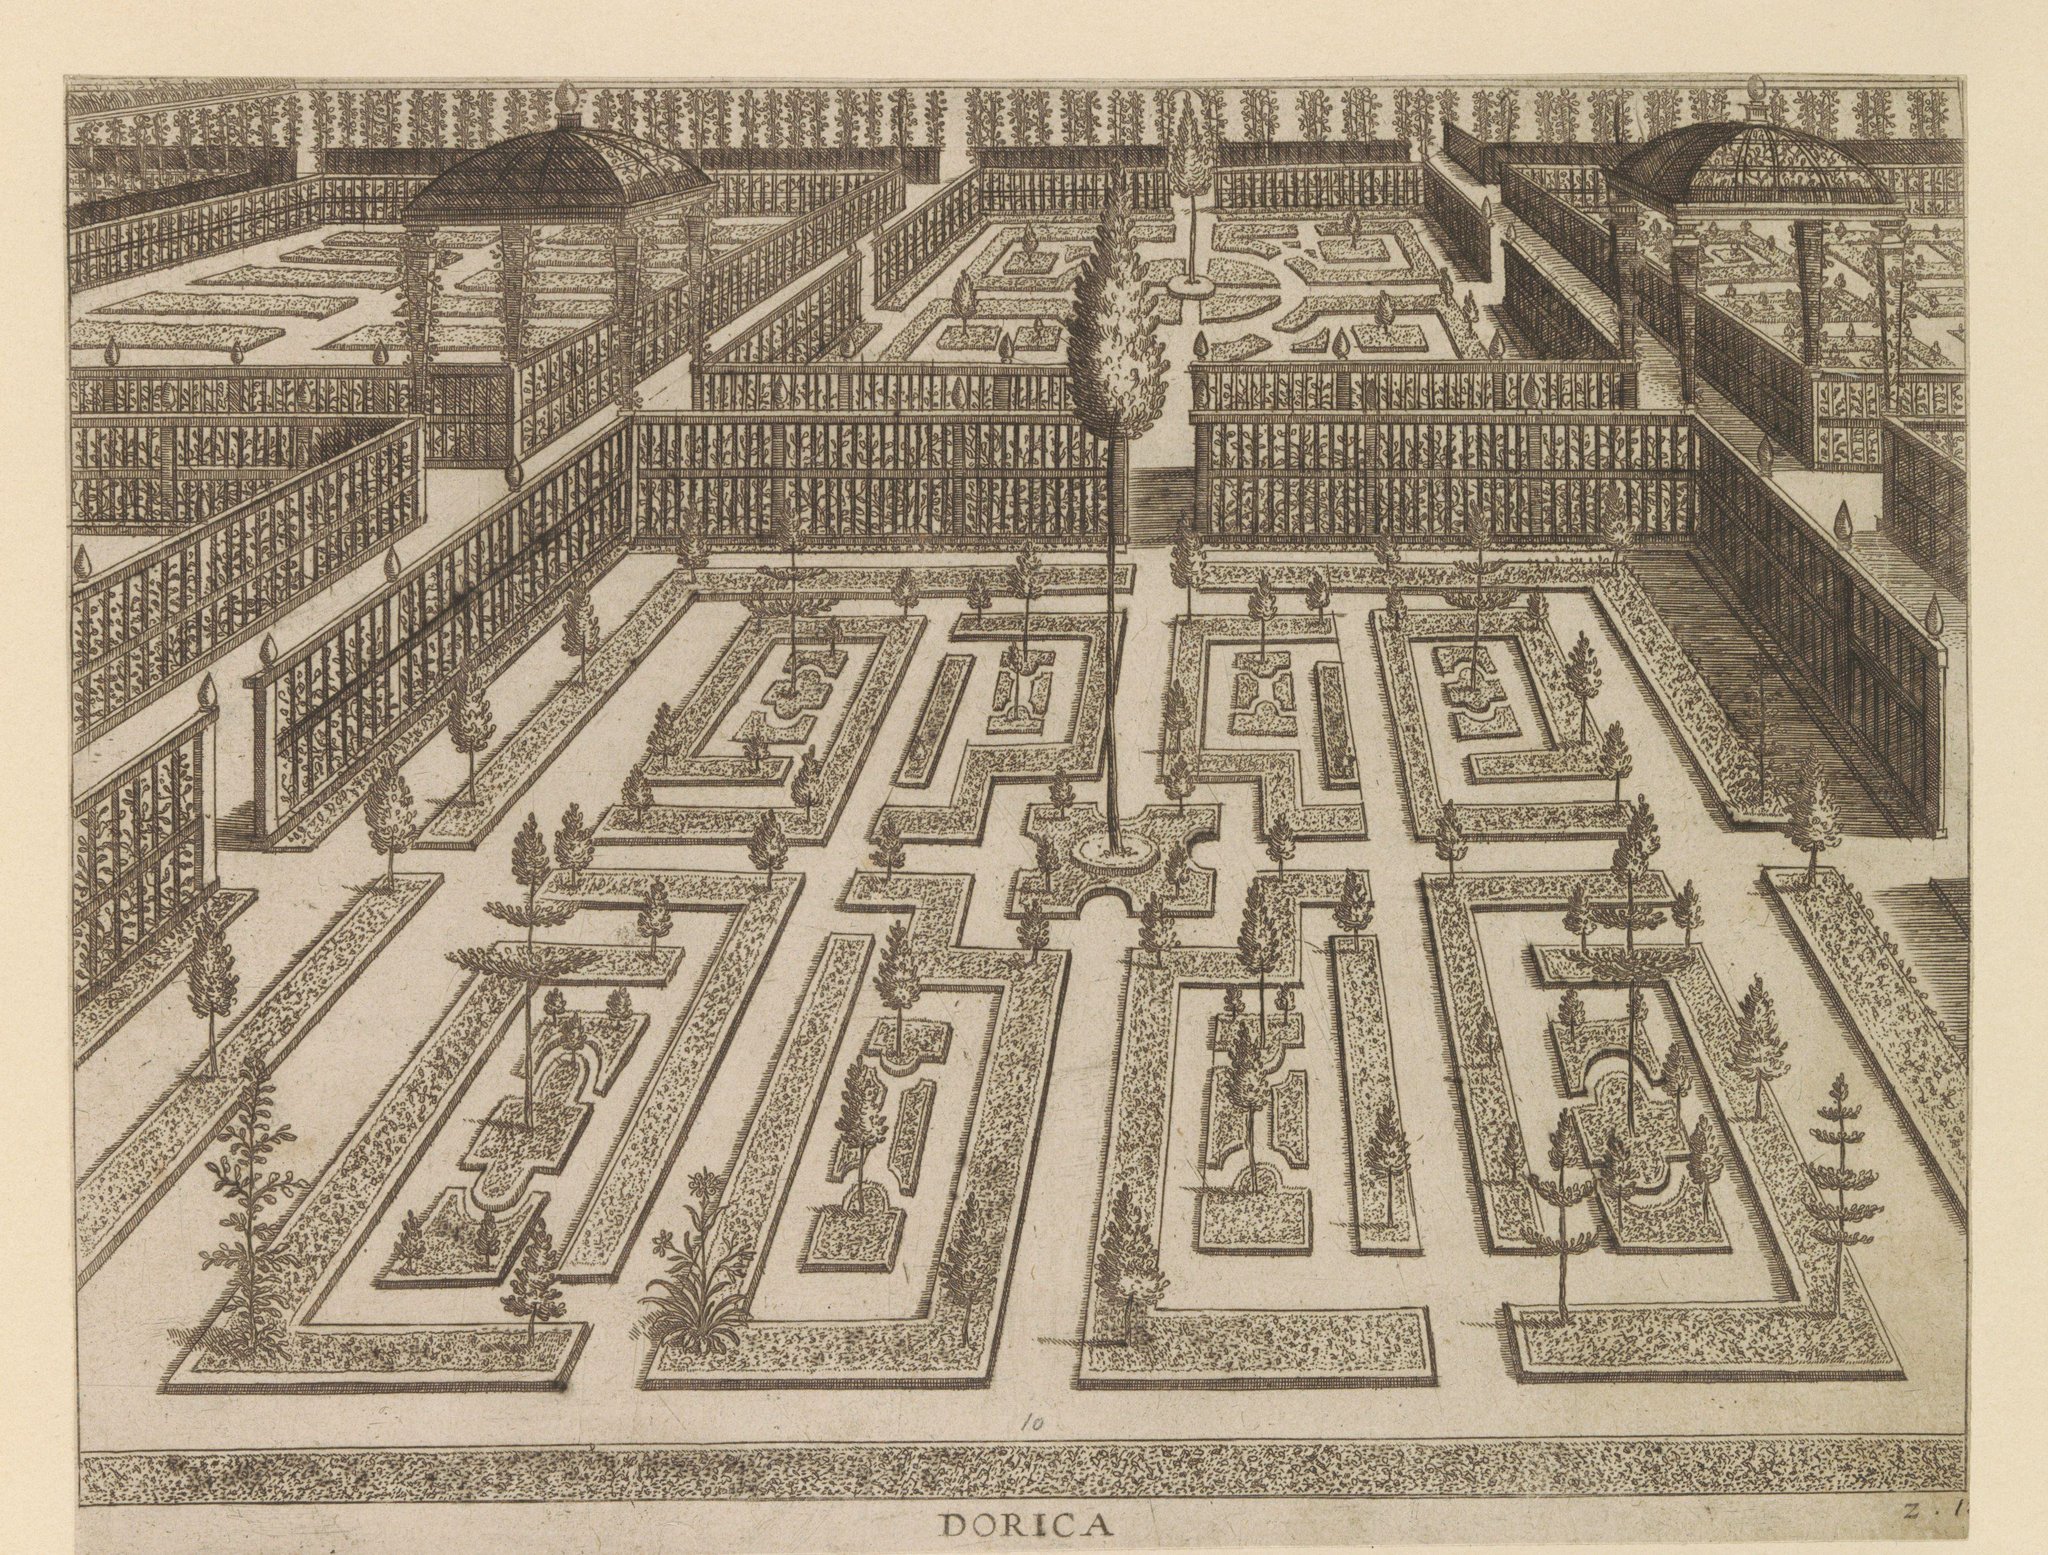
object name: ornament print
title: Tuin met een parterre bestaande uit acht rechthoekige compartimenten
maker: Anonymous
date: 1583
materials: paper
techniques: etching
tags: garden, french or architectonic garden; formal garden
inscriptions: inscription: ‘10’, inscription: ‘1’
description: Tuin met centrale parterre bestaande uit acht rechthoekige compartimenten. Omgeven door hekken waar planten tegenop groeien. De tuin is aangelegd volgens de Dorische bouworde. De prent maakt deel uit van een album.